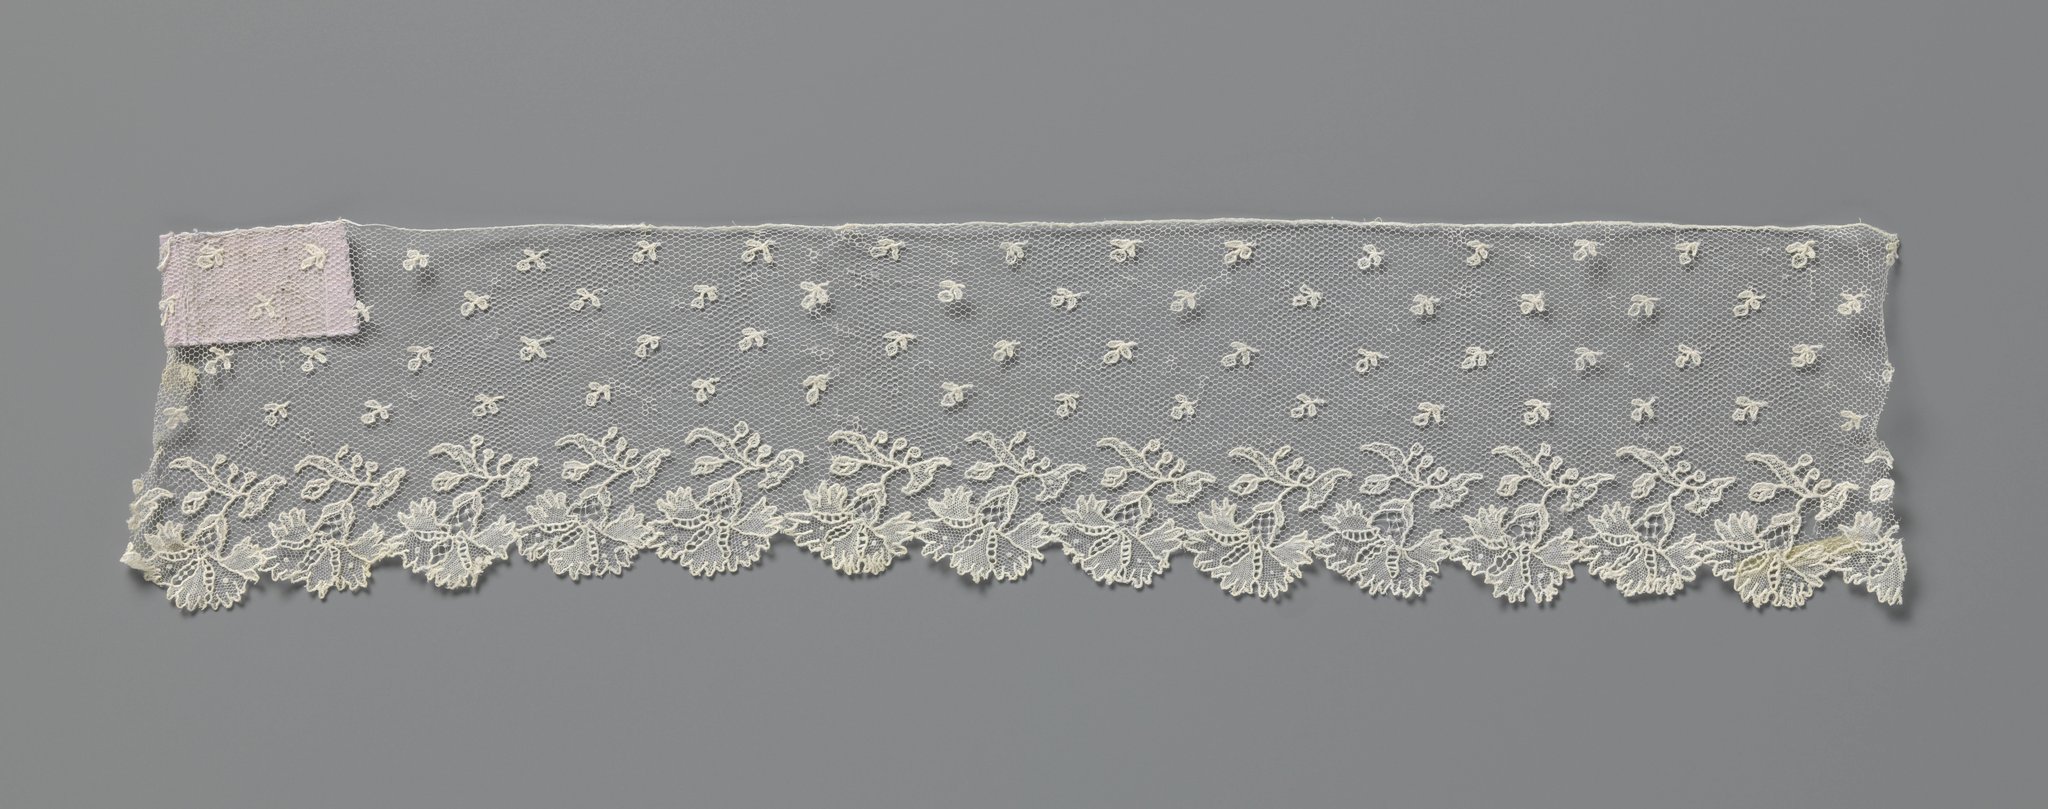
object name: strip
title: Strook applicatiekant met korenbloemenrand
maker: Anonymous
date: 1830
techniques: lace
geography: brussels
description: Strook naturelkleurig applicatiekant, naaldkant op drochelgrond, point d'Angleterre. Strooimotief van ronde bloempjes met twee blaadjes aan korte stengel op een fijne zeshoekige maasgrond. Repetitief motief langs de onderkant van een hangende korenbloemachtige bloem. De schulpenrand aan de onderzijde wordt gevormd door deze bloemen. Reliëfcontouren rond de motieven zijn gemaakt van wijd gefestonneerde draadbundels. Enkele siersteken in de bloemen. De bovenzijde is afgewerkt met een rechte rand.